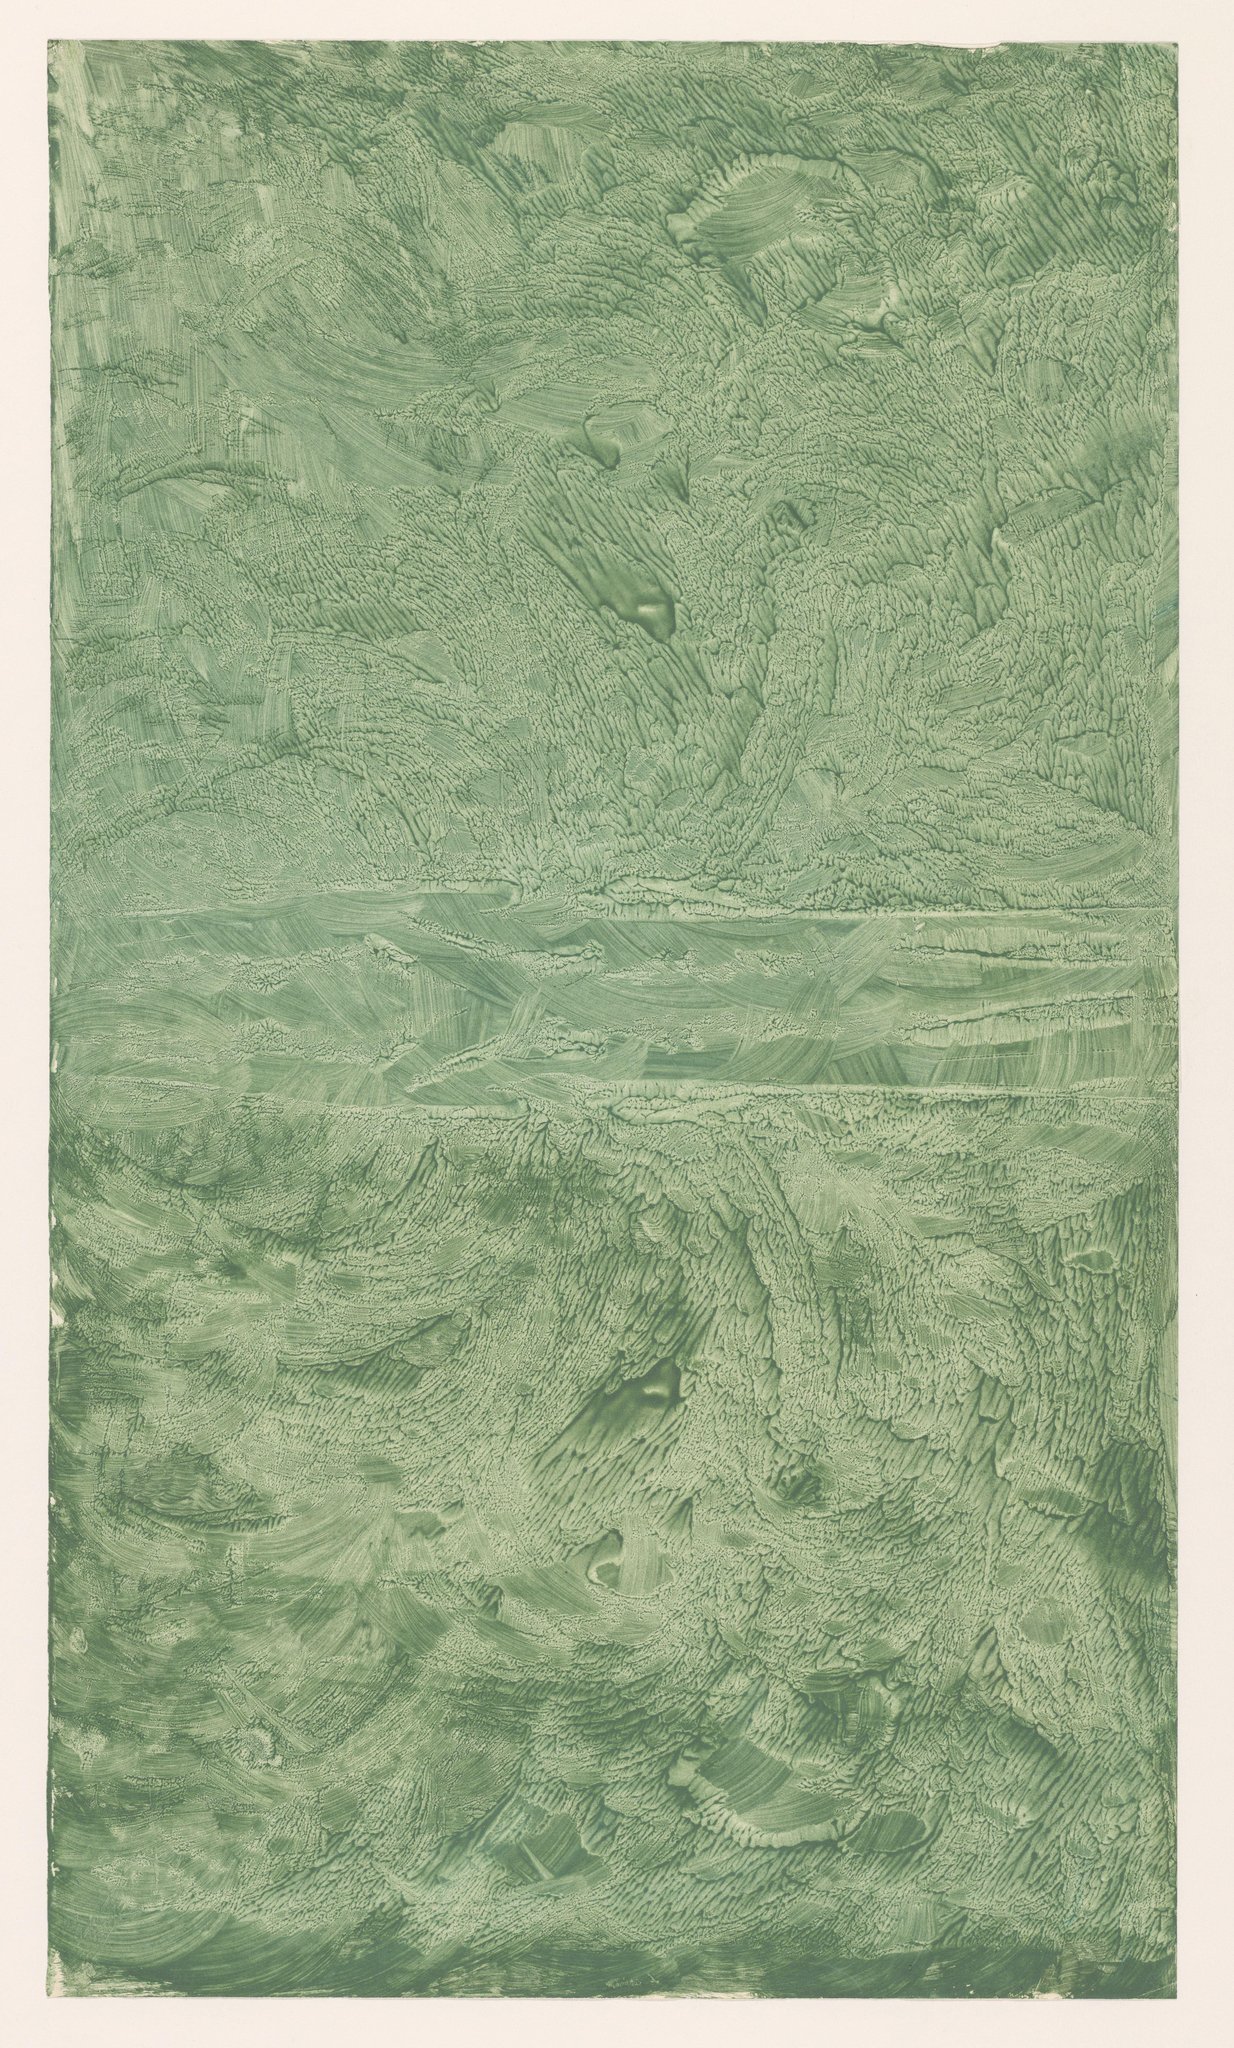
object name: paste paper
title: Stijfselverfpapier in groen met ingekwaste decoratie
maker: Anonymous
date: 1900-1969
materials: paper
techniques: starch dyeing